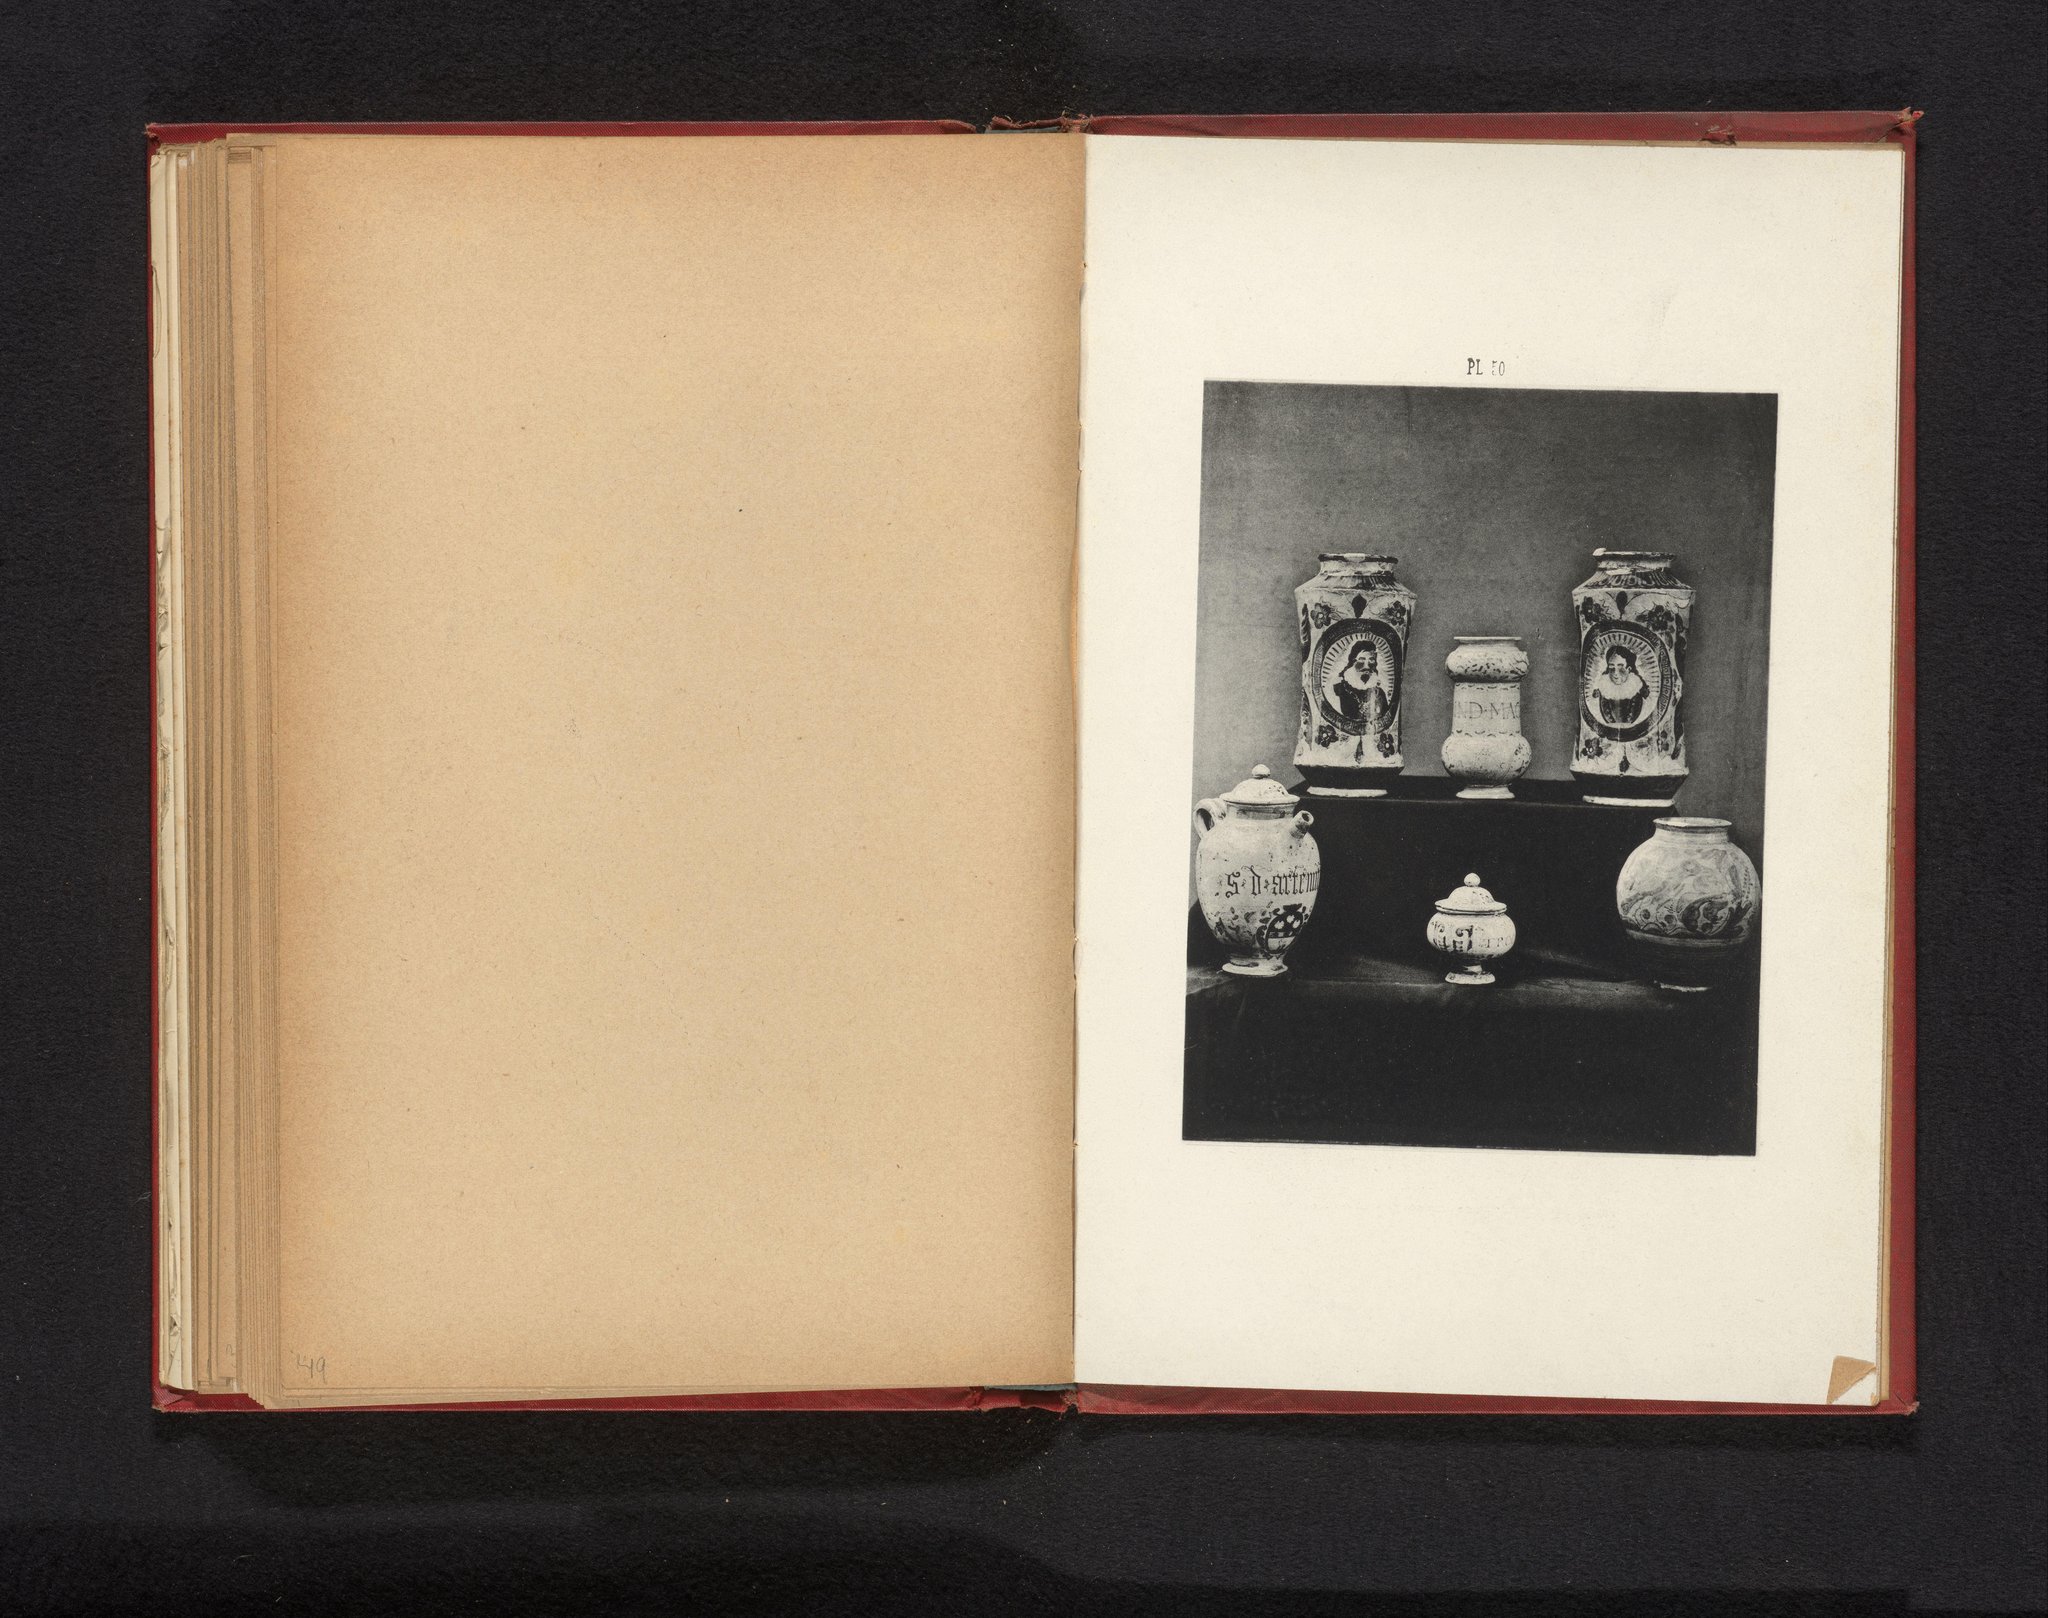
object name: photomechanical print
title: Opstelling van zes vazen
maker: Anonymous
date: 1880-1881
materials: paper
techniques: photograph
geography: barcelona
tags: container of ceramics: jar, jug, pot, vase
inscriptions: number: ‘Pl 50’